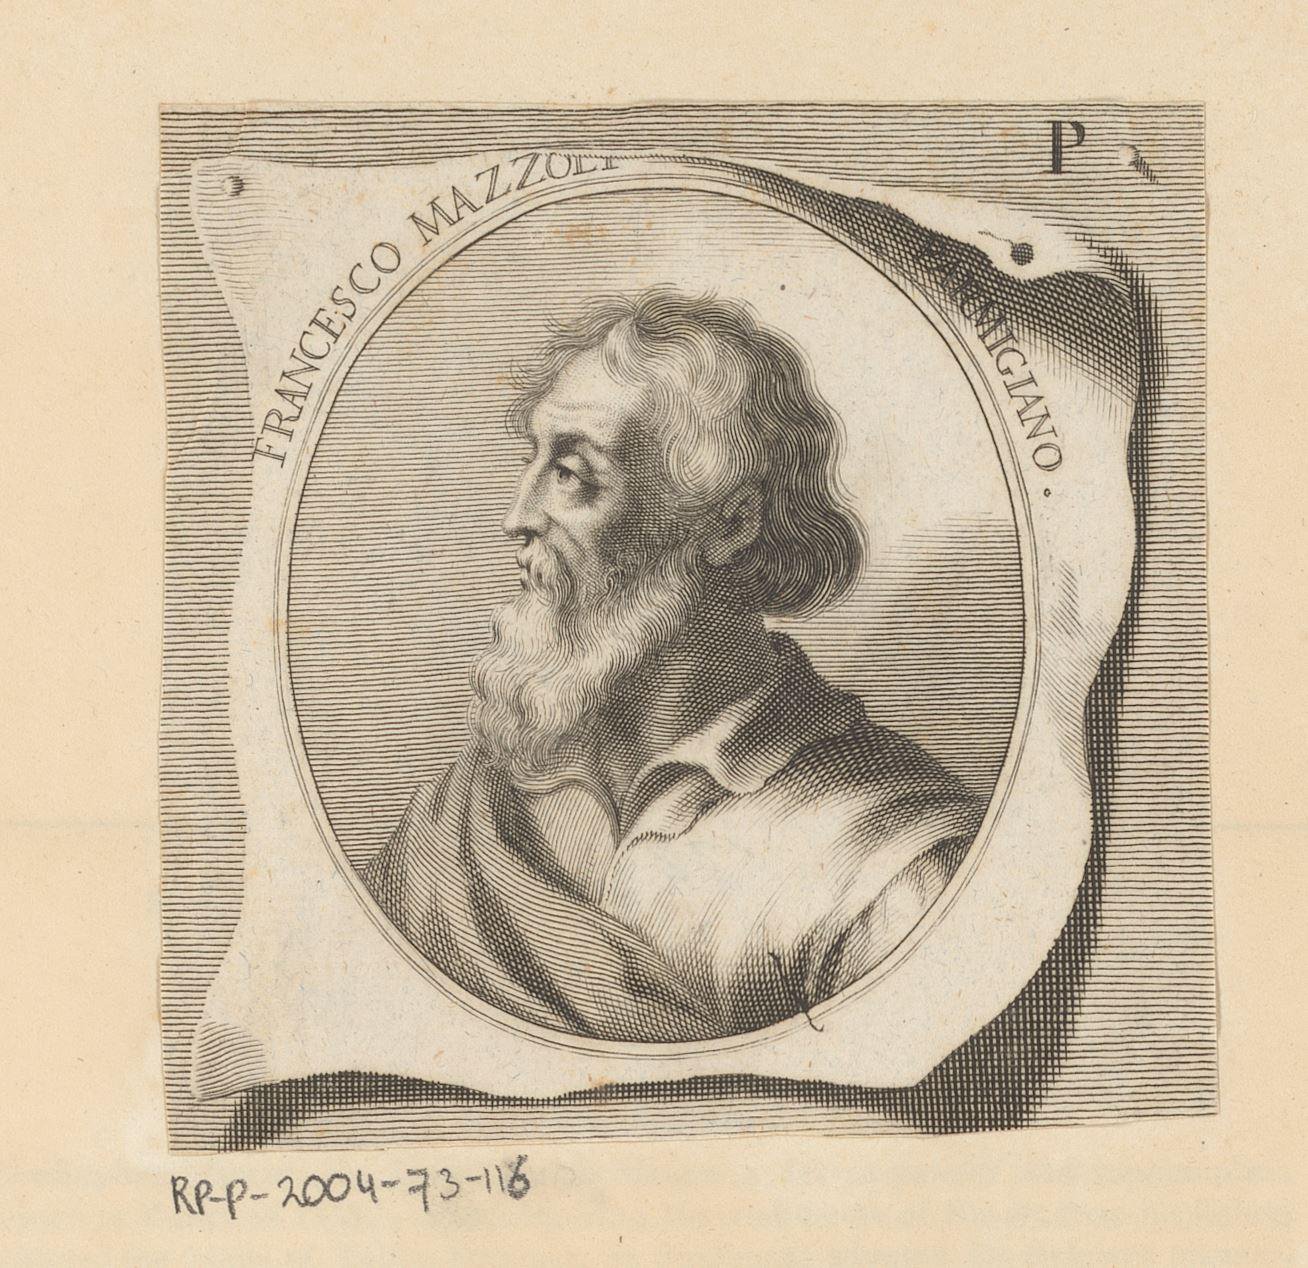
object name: book illustration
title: Francesco Mazzoli Parmigiano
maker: philipp kilian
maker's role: print maker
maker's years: 1628-1693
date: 1768-1775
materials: paper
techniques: engraving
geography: nuremberg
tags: painter, print maker, draughtsman, parmigianino, historical persons, portrait, self-portrait of painter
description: Prent uit: Sandrart, Joachim von. Teutsche Academie der Bau- Bildhauer- und Maler-Kunst: worinn die Regeln und Lehrsätze dieser Künste gegeben. 14 dln. Neurenberg: erven Johann Andreas Endter, [1774], dl. 7, p. P. De samensteller heeft deze prent in het album geplakt als illustratie bij: Pilkington, Matthew en Johann Heinrich Füssli. A dictionary of painters, from the revival of the art to the present period. 4 dln. Londen: John Crowder, 1805, dl. 2, p. 322.